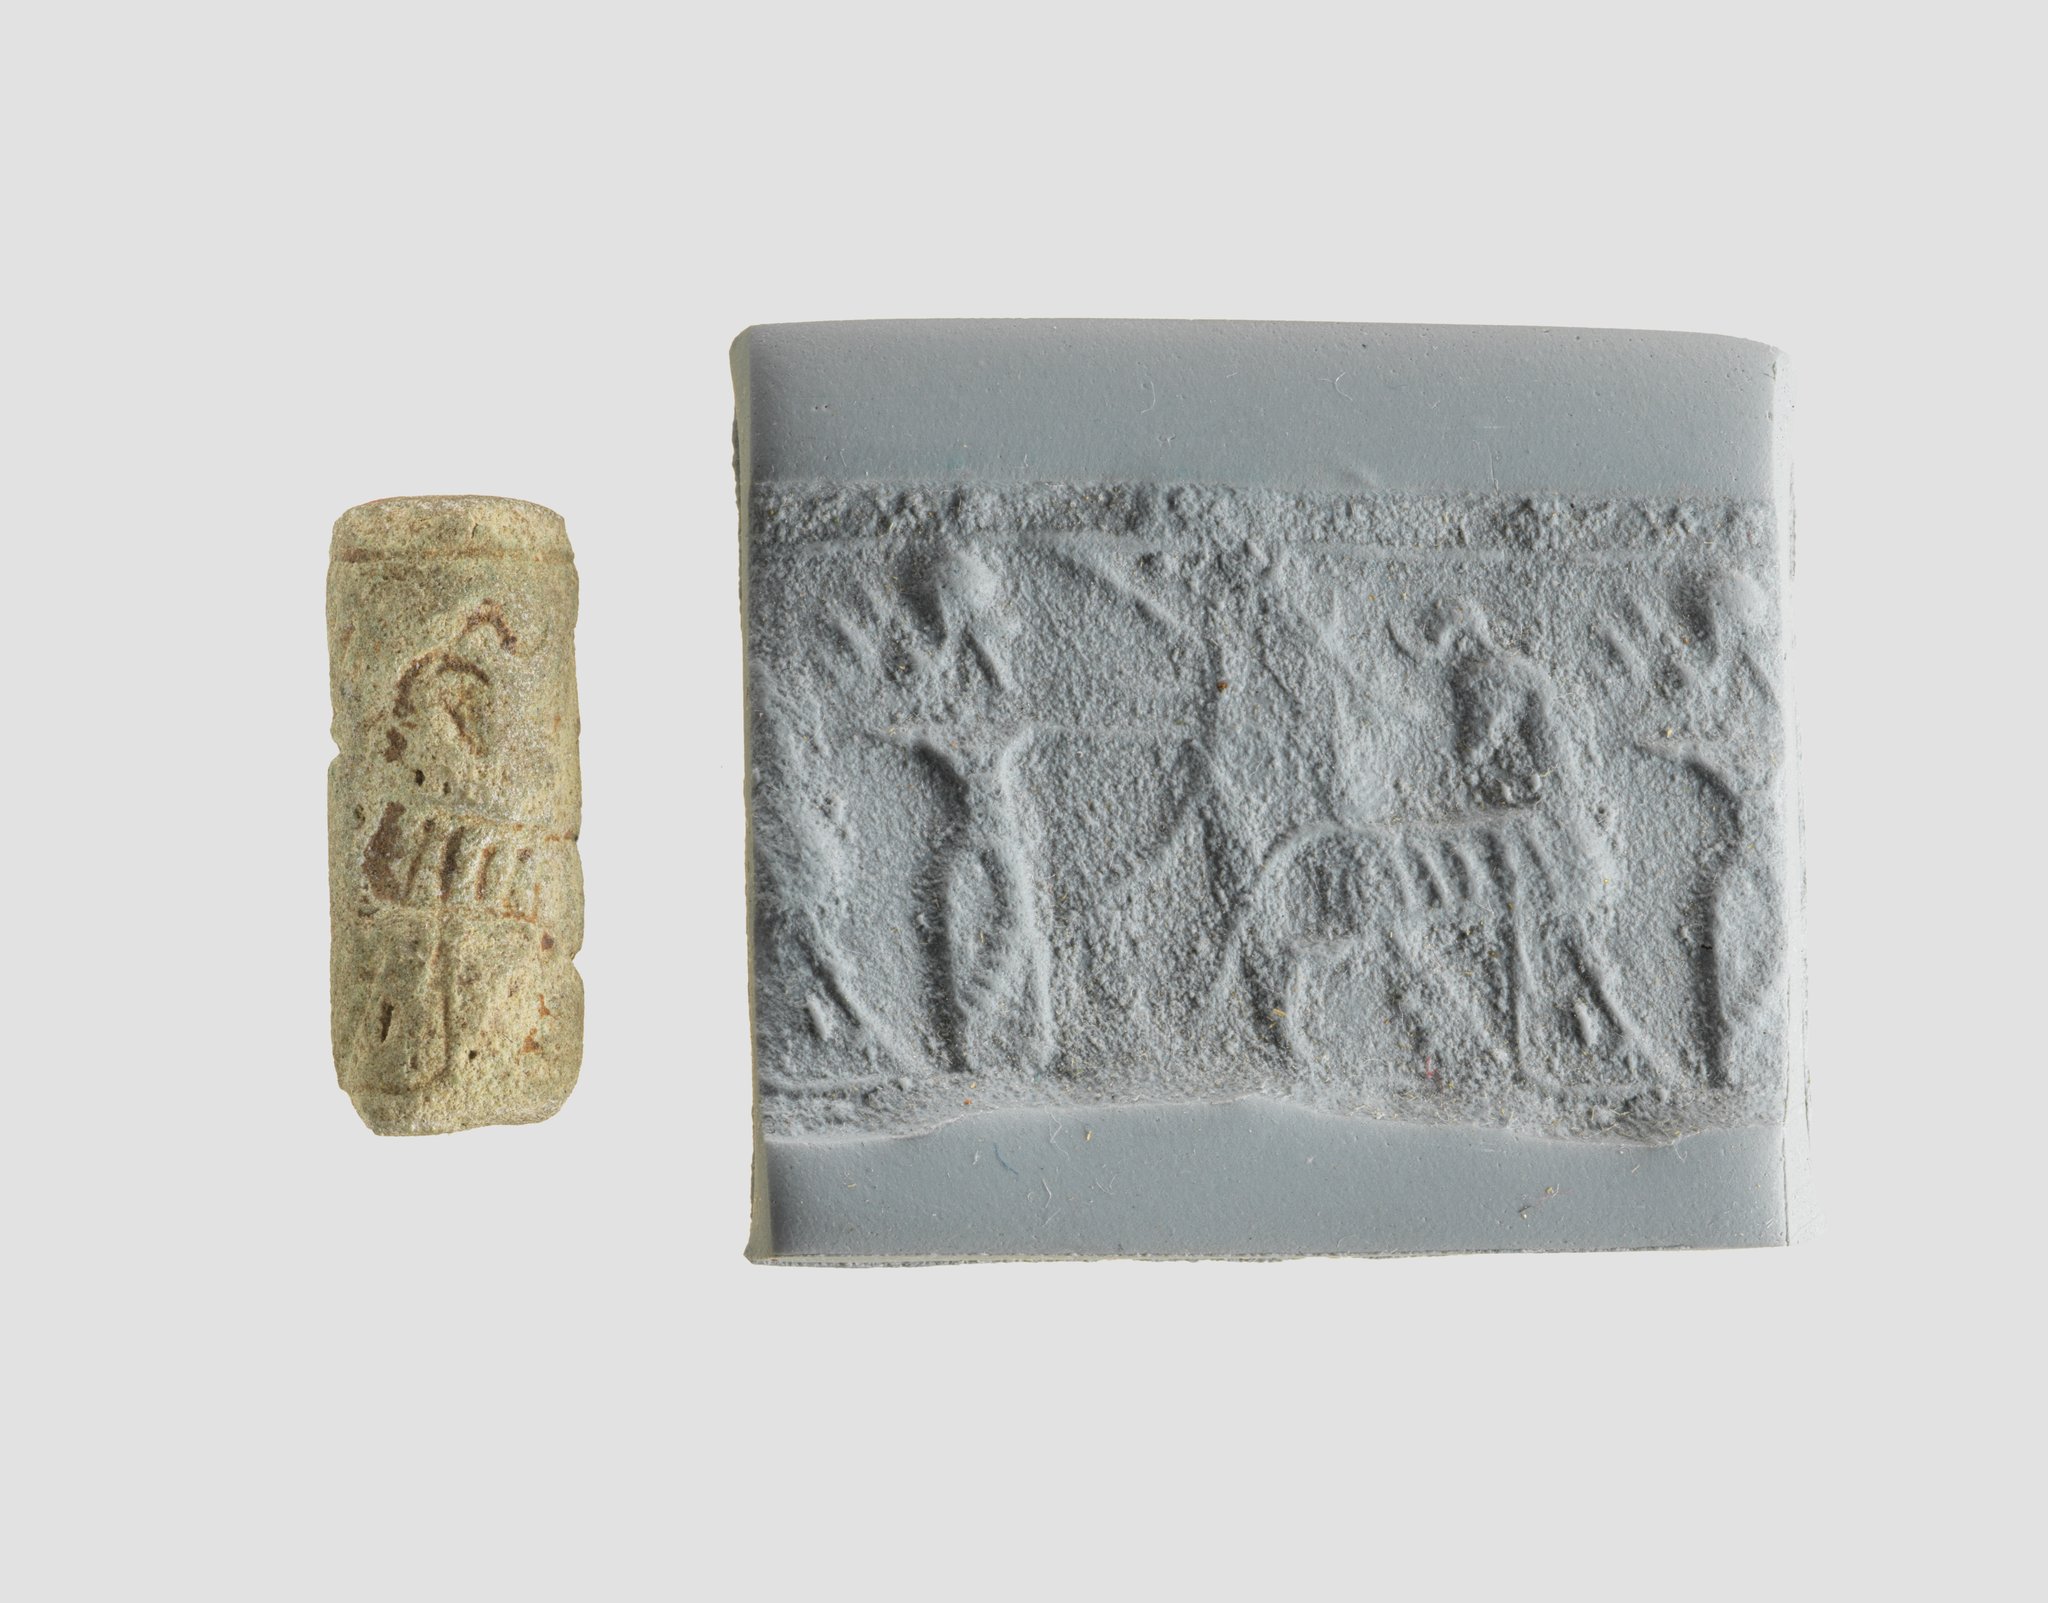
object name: cylinder seal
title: Cylinder seal with hunting scene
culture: assyrian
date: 834-668 BCE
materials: faience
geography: iran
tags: animals